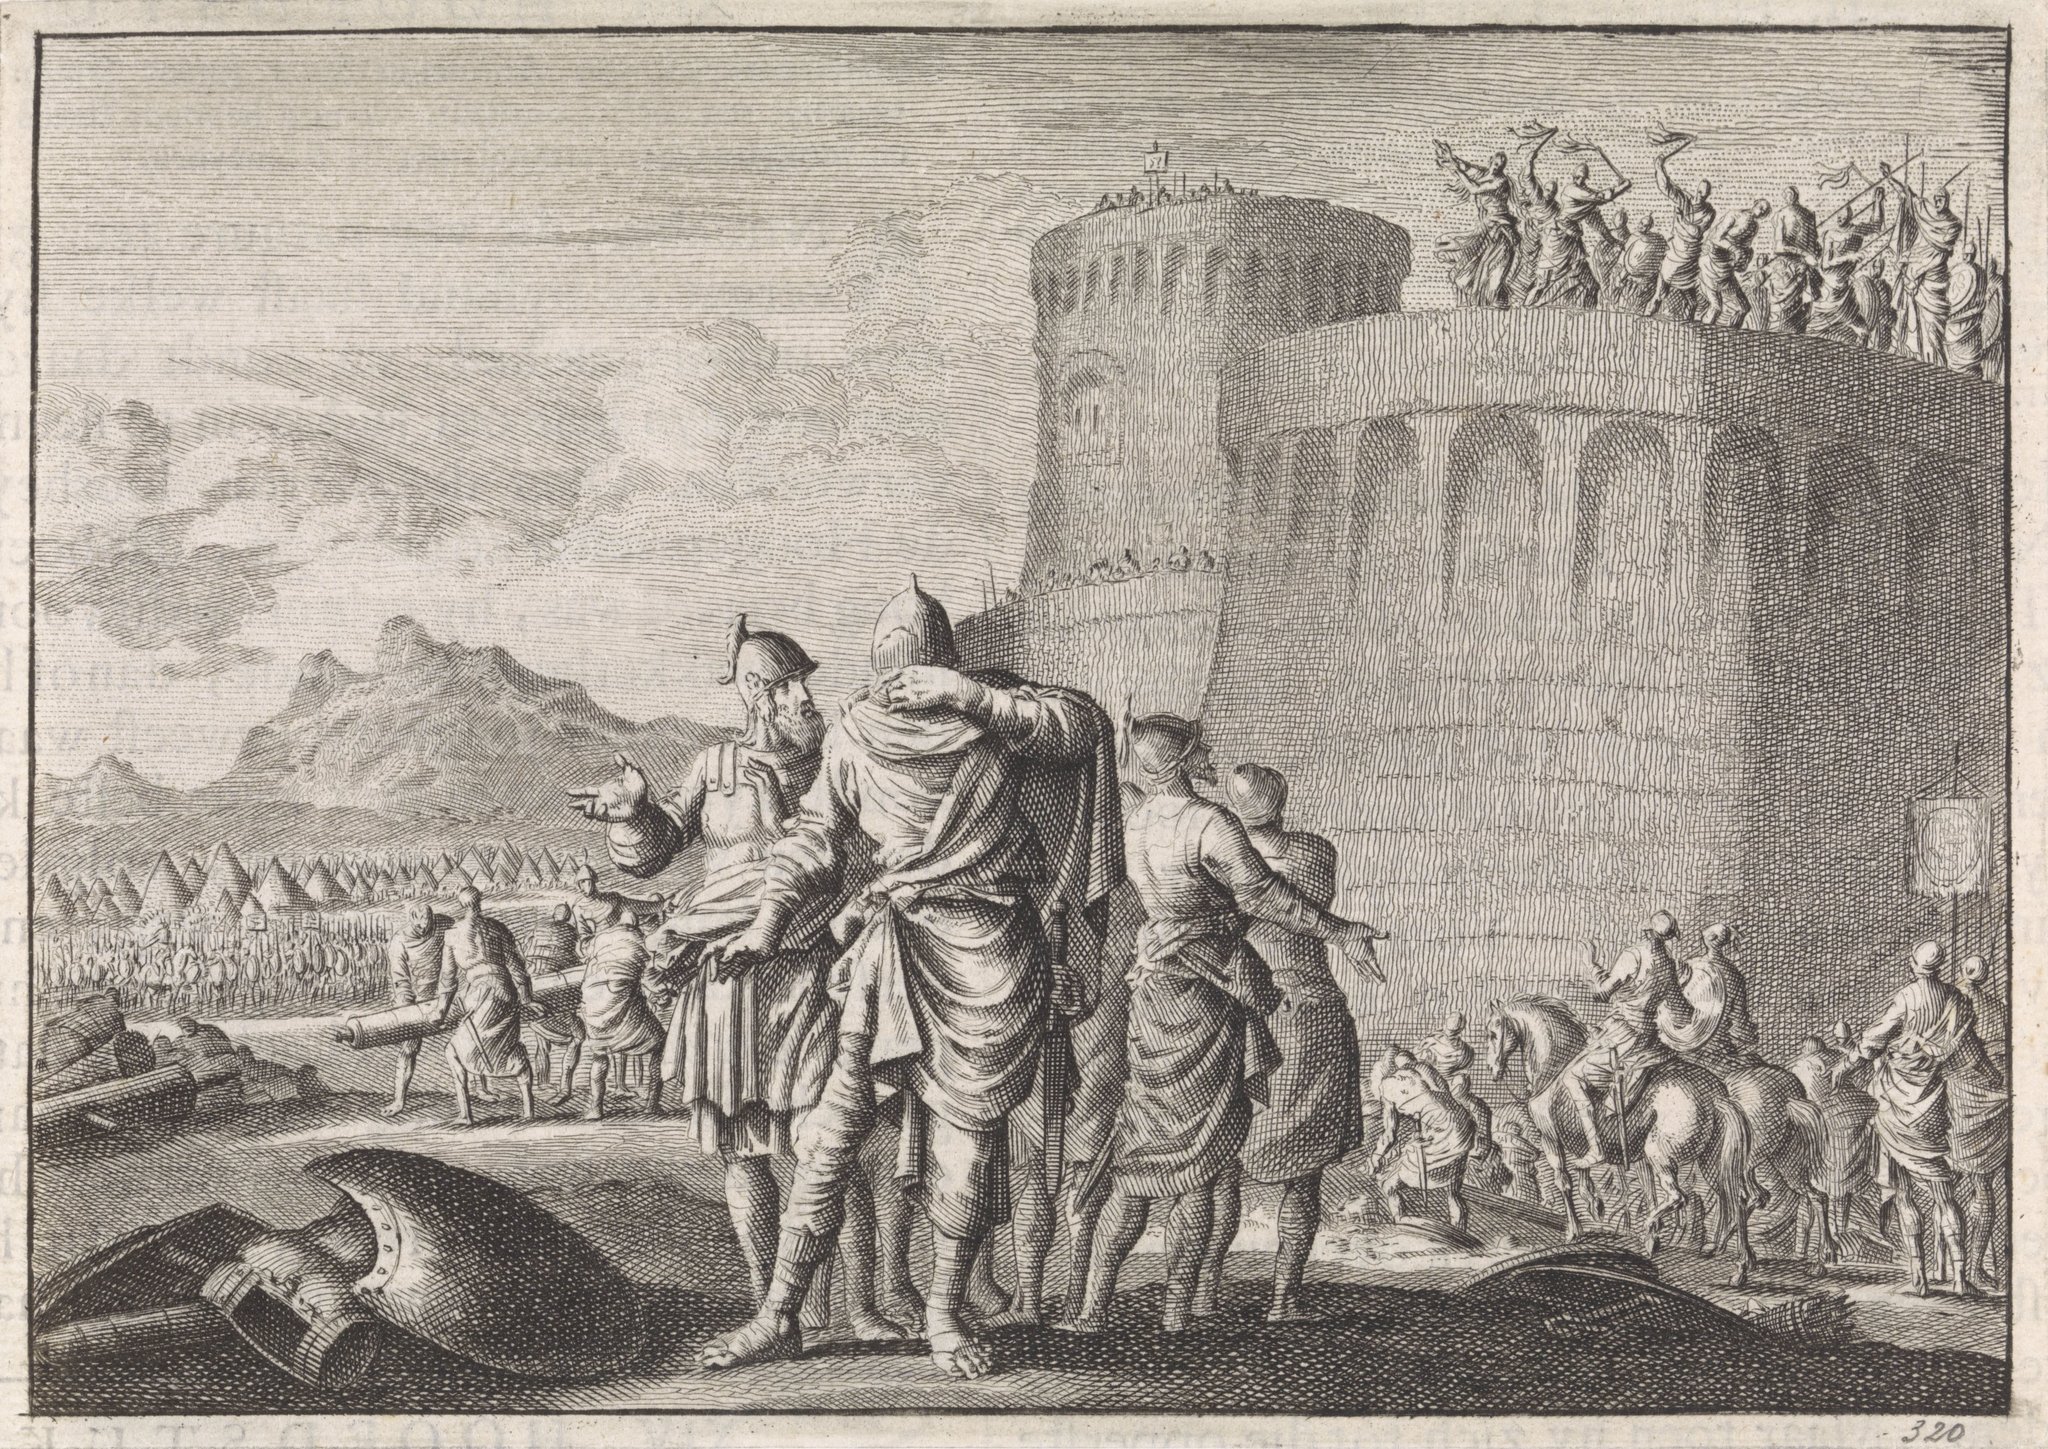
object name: book illustration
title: Hyrkanus, Simons zoon, wendt zich af tijdens het beleg van het slot Dagon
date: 1704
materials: paper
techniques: etching, letterpress printing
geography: amsterdam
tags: john hyrcanus appointed leader of the maccabees (1 maccabees 16:19-22)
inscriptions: collector's mark: Lugt 2228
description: Prent opgenomen in: Josephus, Flavius. Alle de Werken, 2 delen. Amsterdam: Pieter Mortier, 1704, dl. 1, p. 320.